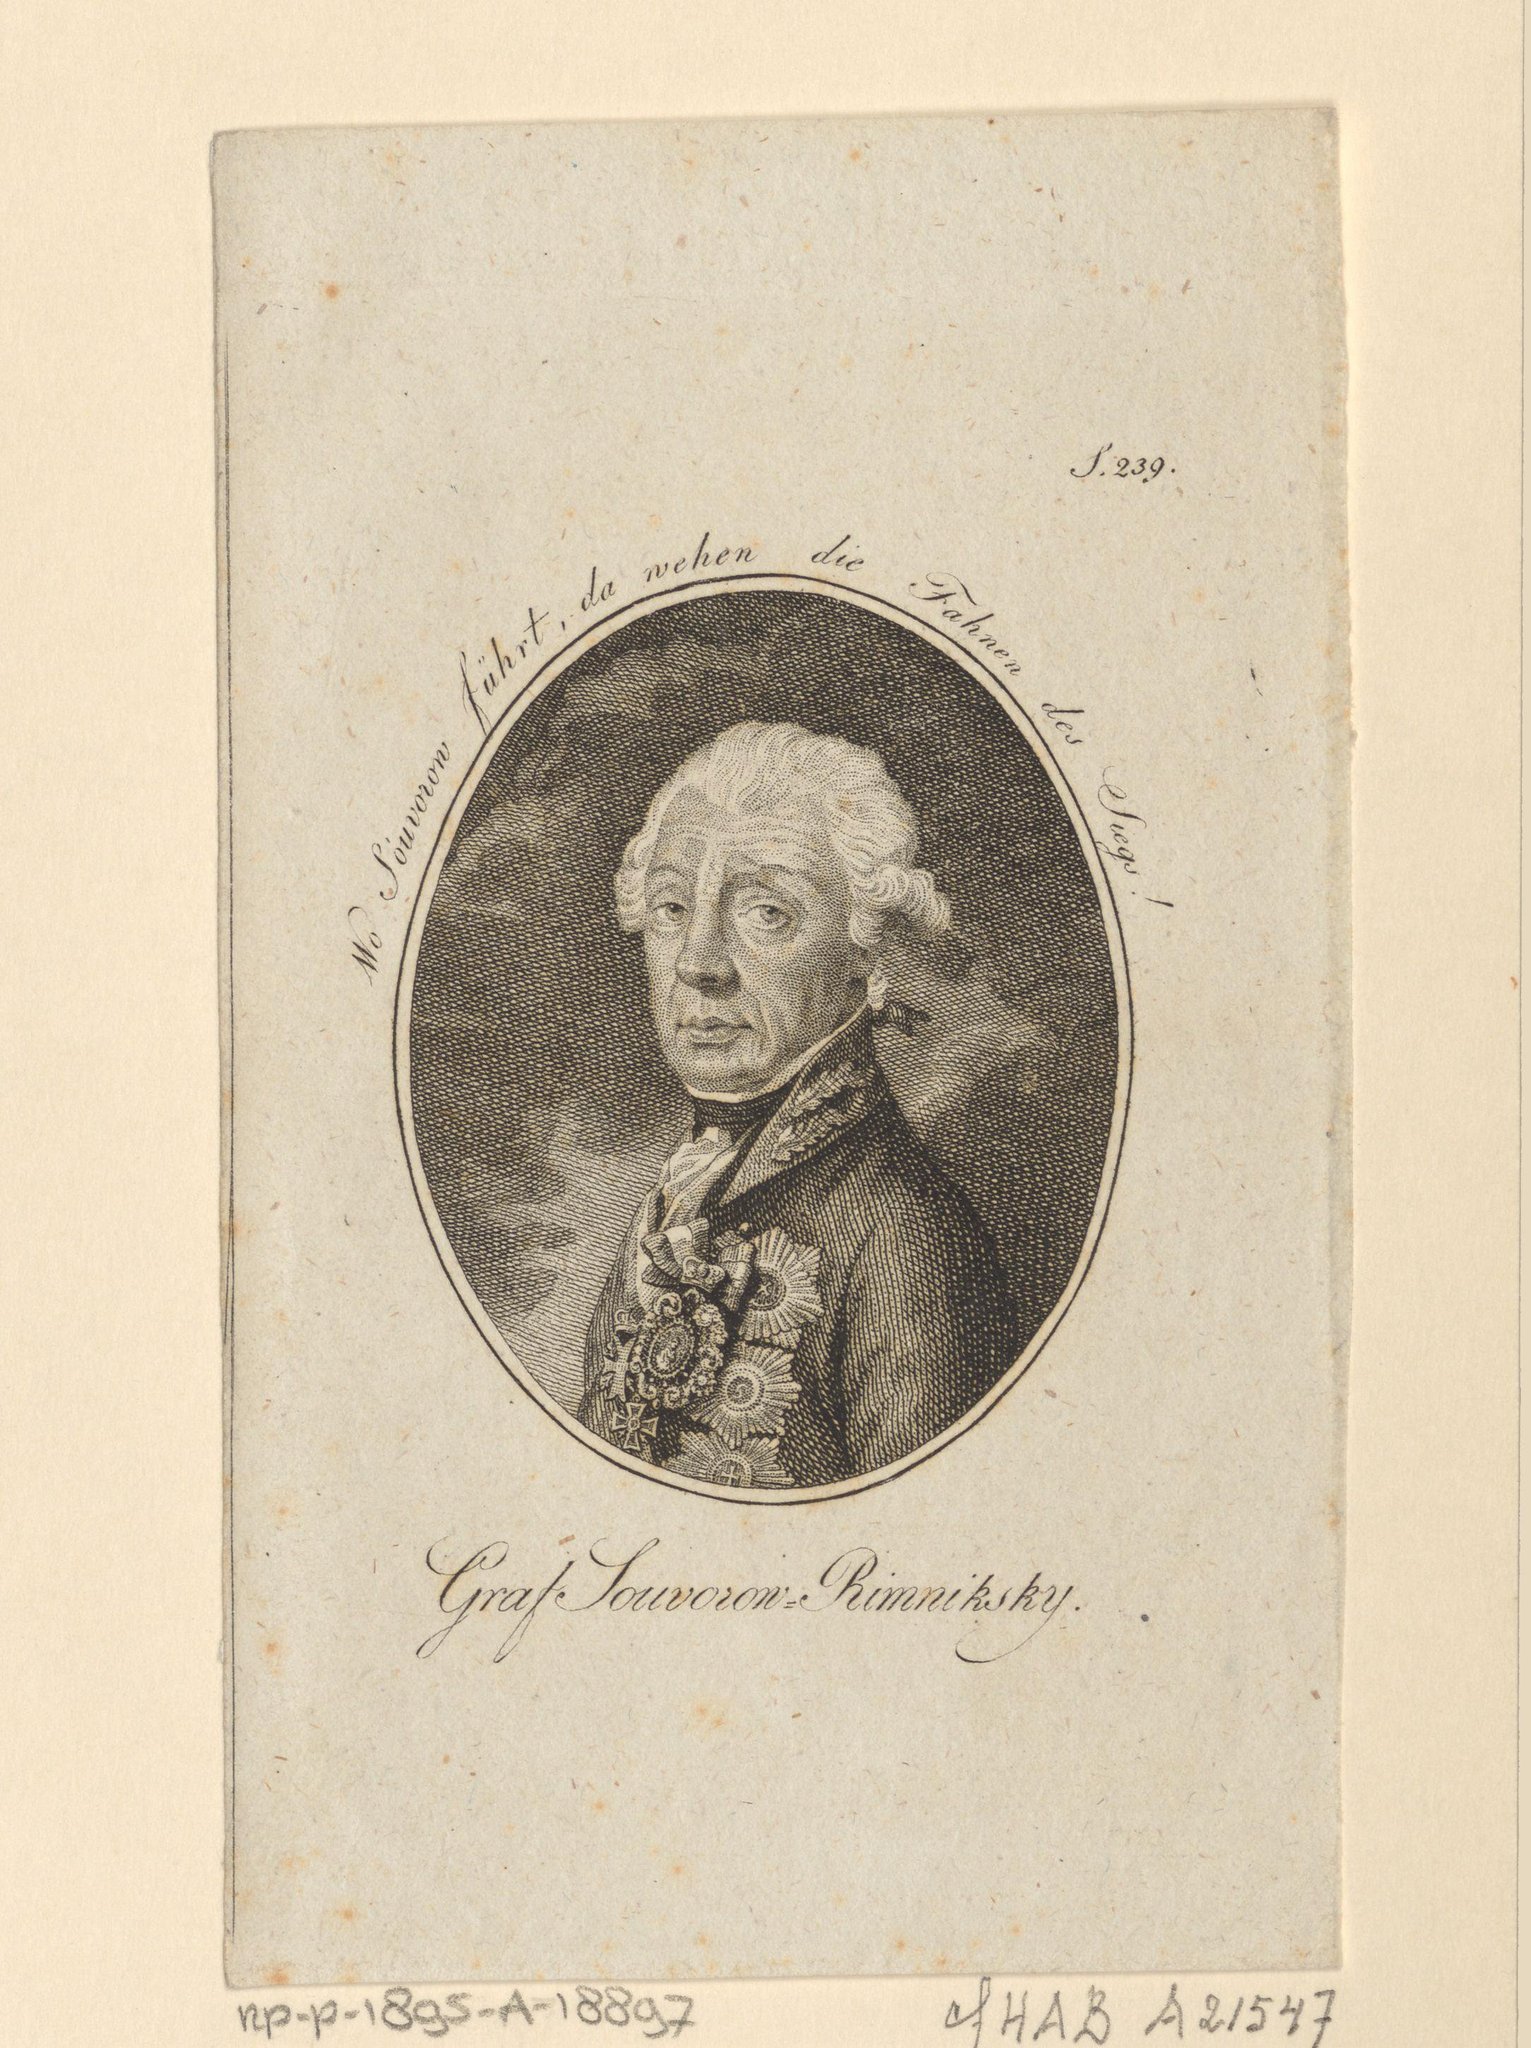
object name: print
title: Portret van Aleksandr Soevorov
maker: Anonymous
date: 1779-1899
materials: paper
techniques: engraving, etching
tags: commander-in-chief, general, marshal, historical persons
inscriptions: collector's mark: Lugt 2228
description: Met eenregelig bovenschrift in het Duits. Rechtsboven genummerd: S. 239.